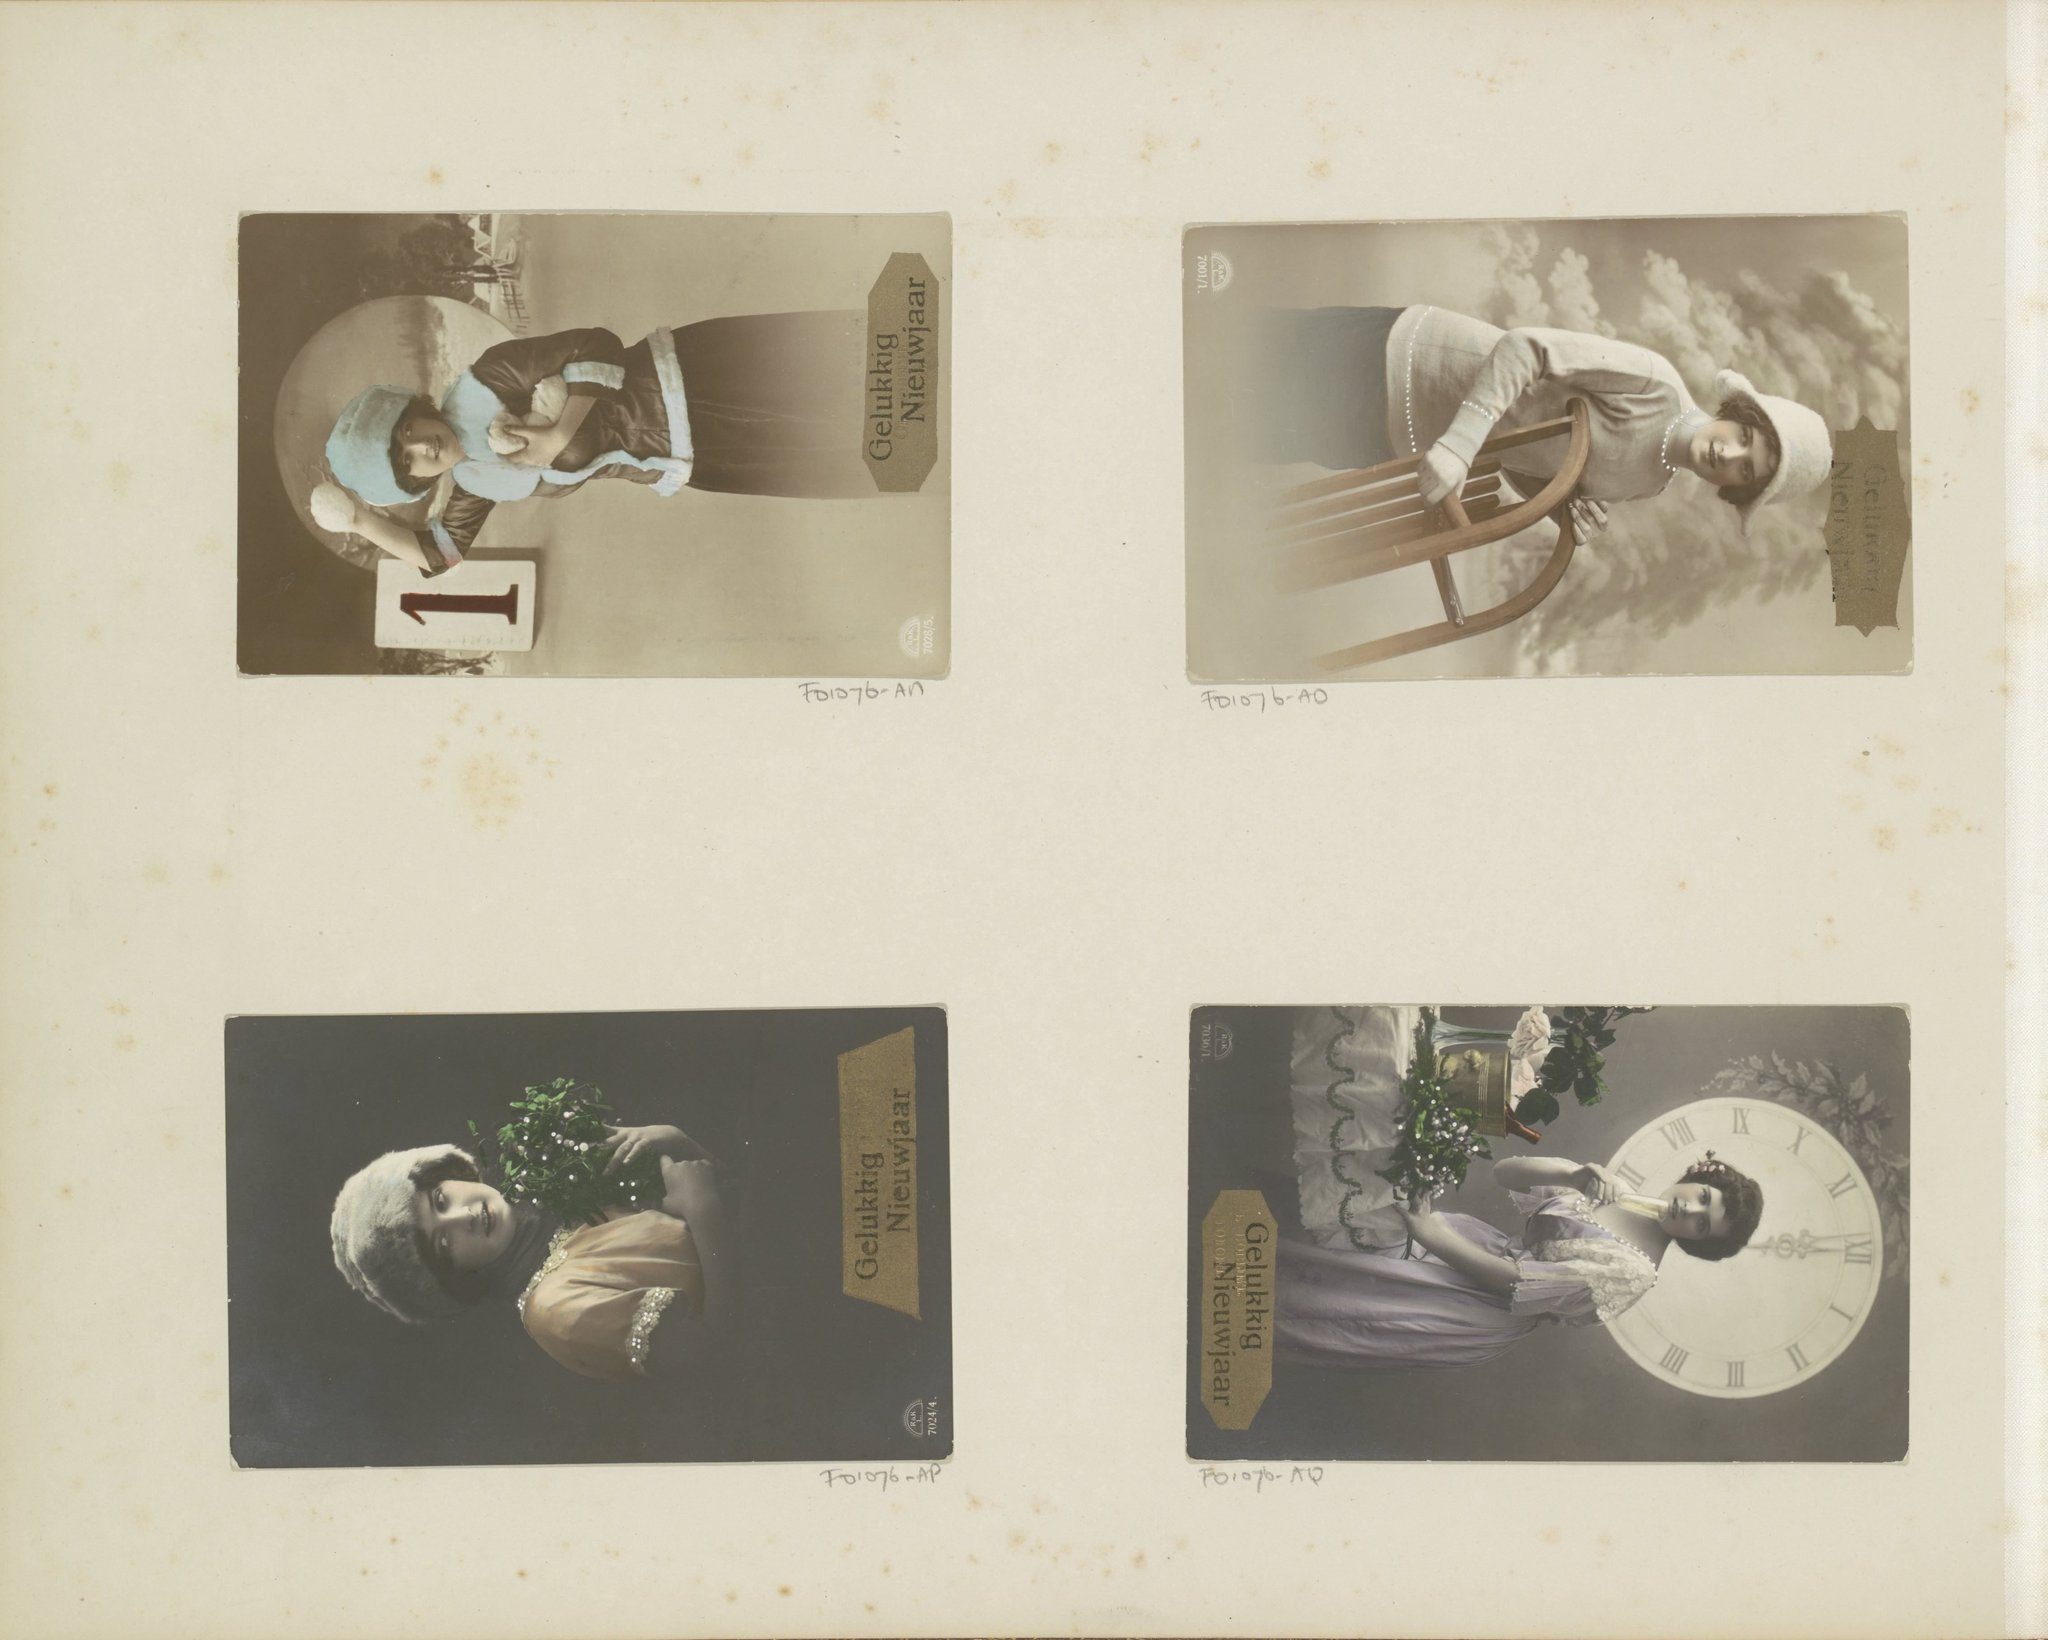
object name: ansichtkaart, prentbriefkaart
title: Nieuwjaarskaart met een portret van een vrouw met bontmuts en bessentakken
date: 1910-1940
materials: cardboard, paper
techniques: gelatin silver print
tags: adult woman, head-gear (with name)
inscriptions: number: ‘7024/4.’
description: Onderdeel van Album met foto's van spoorwegen in Nederlands-Indië en prentbriefkaarten.